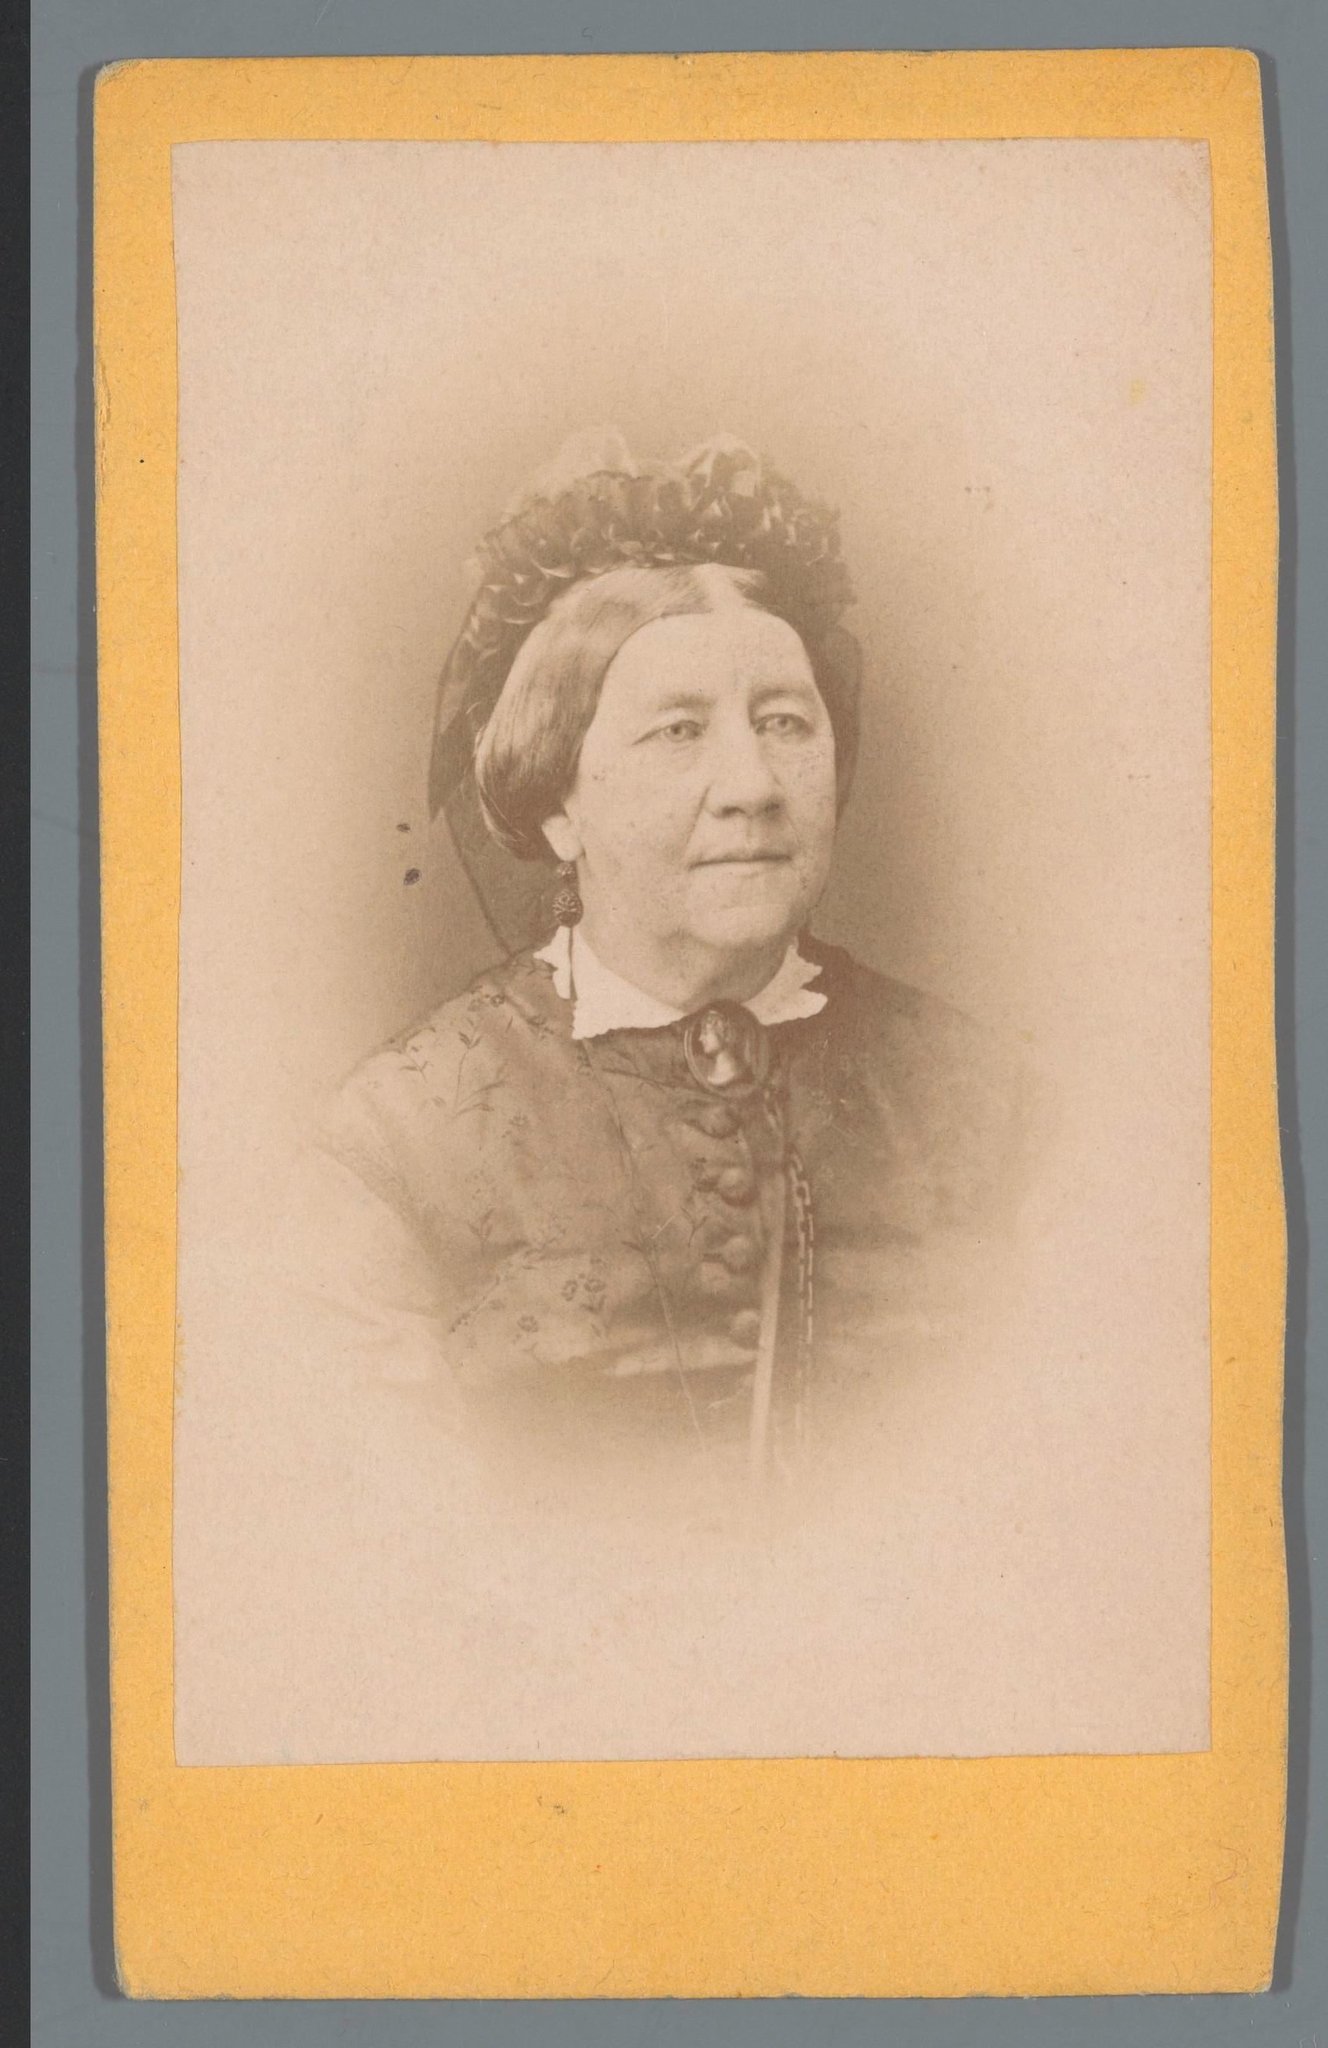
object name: photograph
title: Portret van een oude vrouw, aangeduid als Lucie Stadenberg-Björck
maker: Anonymous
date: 1854-1885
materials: cardboard, paper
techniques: albumen print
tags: historical persons, old woman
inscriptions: inscription: ‘[...]’, name: ‘Lucie Stadenberg/ f Björck.’